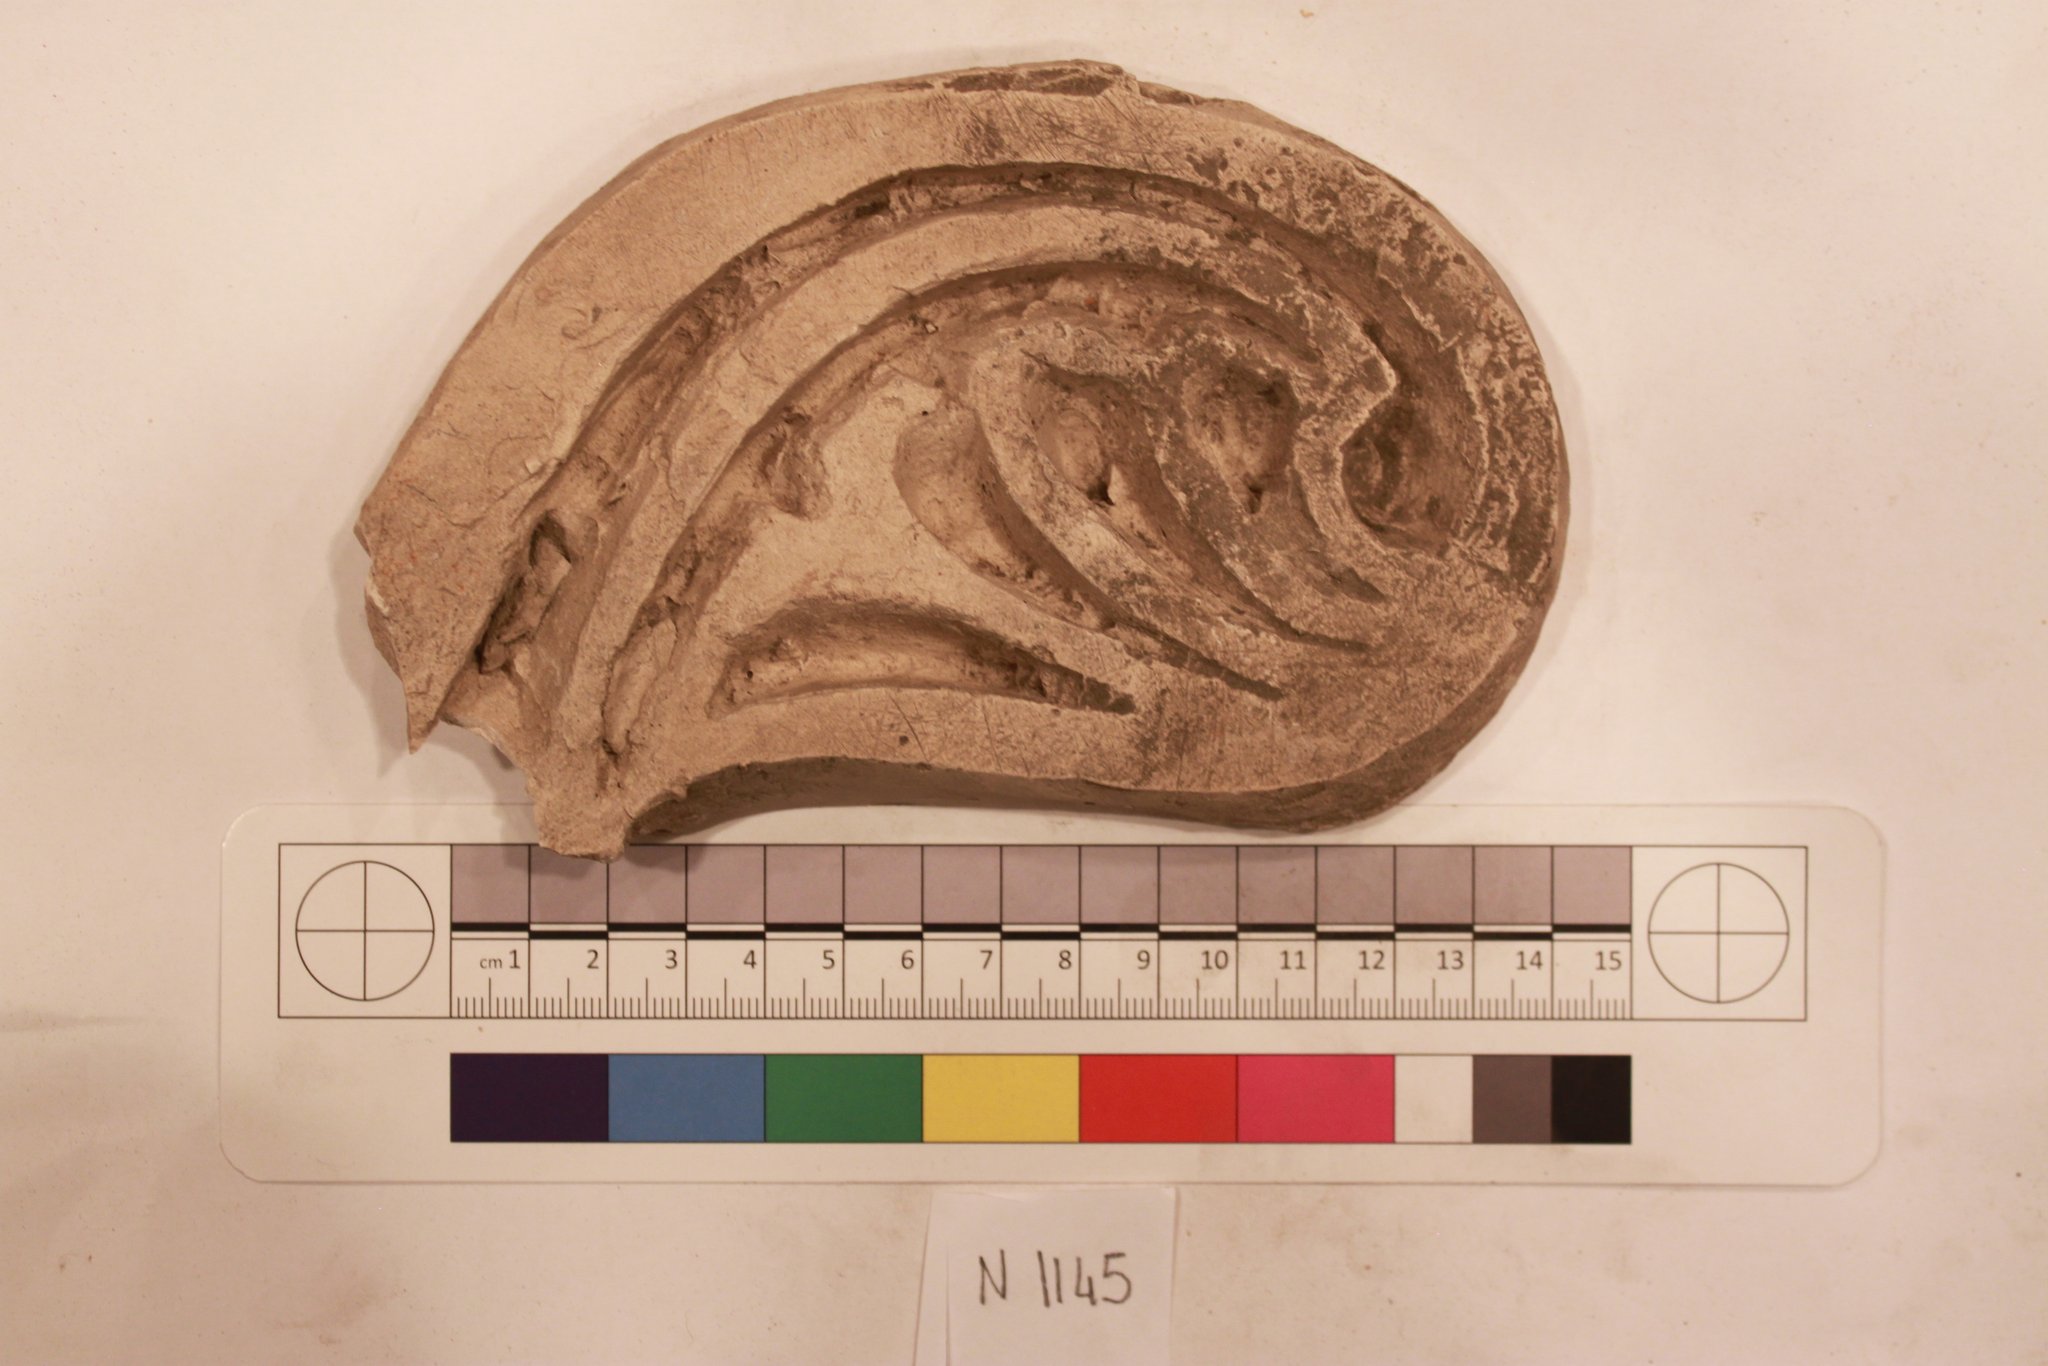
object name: fragment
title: Stucco Fragment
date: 701-1200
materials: gypsum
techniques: carving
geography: iran